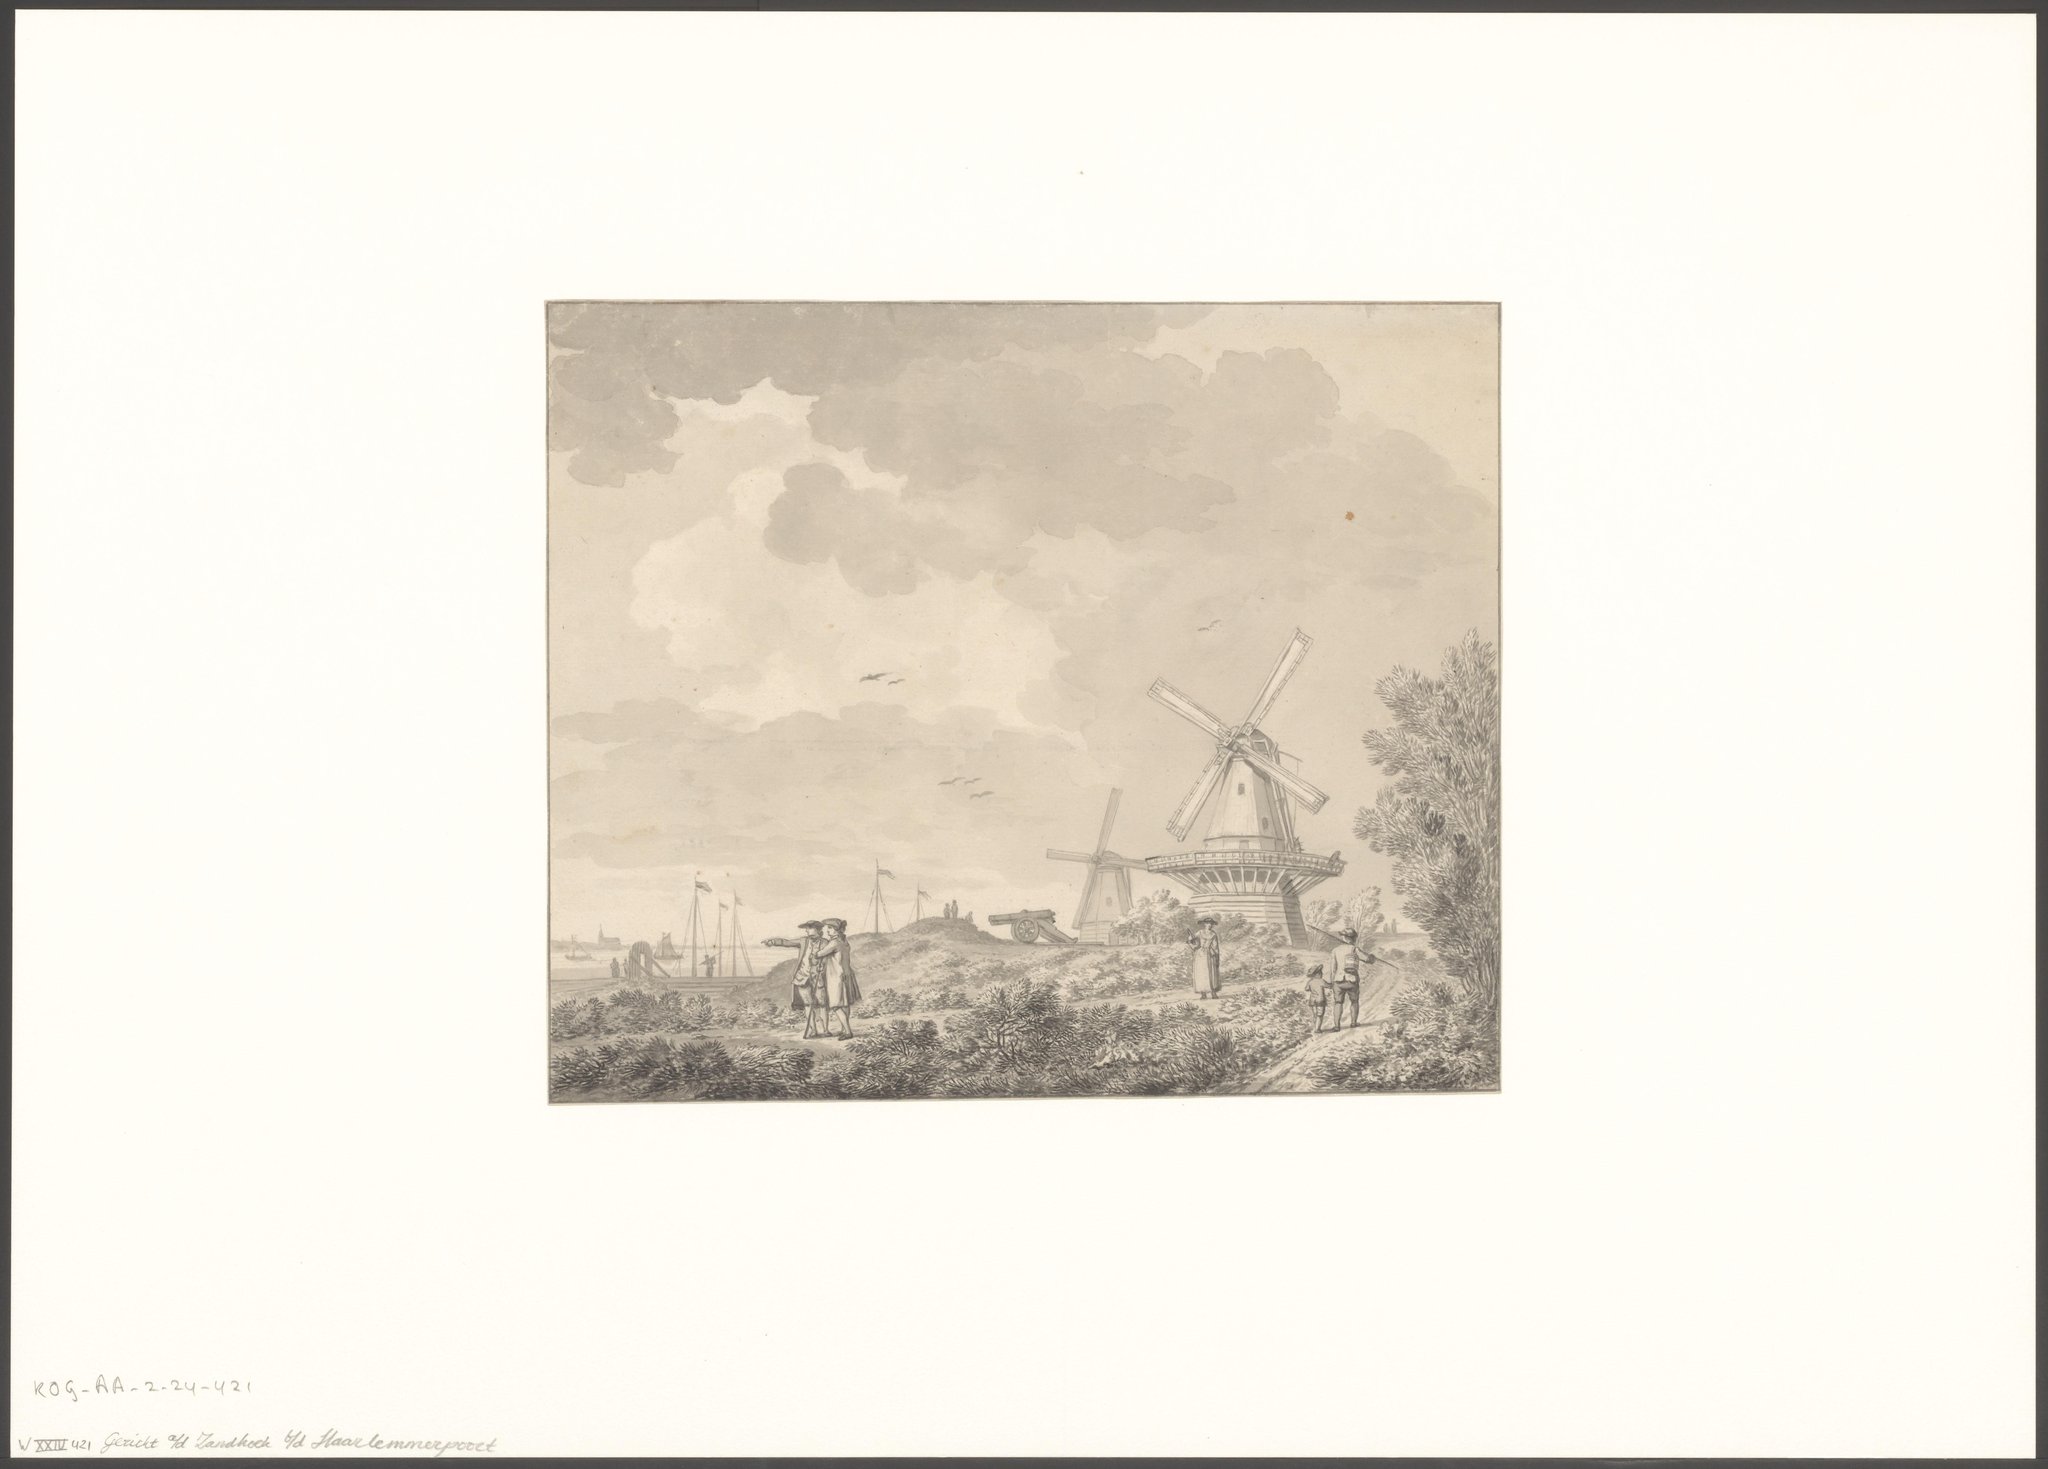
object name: drawing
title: Gezicht op de Zandhoek en bolwerk Blauwhoofd met molen De Bok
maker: anthony andriessen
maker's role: draughtsman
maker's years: 1746-1813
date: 1773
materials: chalk, ink, paper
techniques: brush, pen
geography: amsterdam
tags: city-view in general; 'veduta', river, road, path, windmill in landscape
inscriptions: collector's mark: Lugt 800a, signature and date: ‘A Andriessen del: ad viv: 1773’, inscription: ‘Gezigt van de Zandhoek bijde Haarlemmerpoort’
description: Tekening binnen de Atlas Van Eck ingedeeld op wijknummer 24.